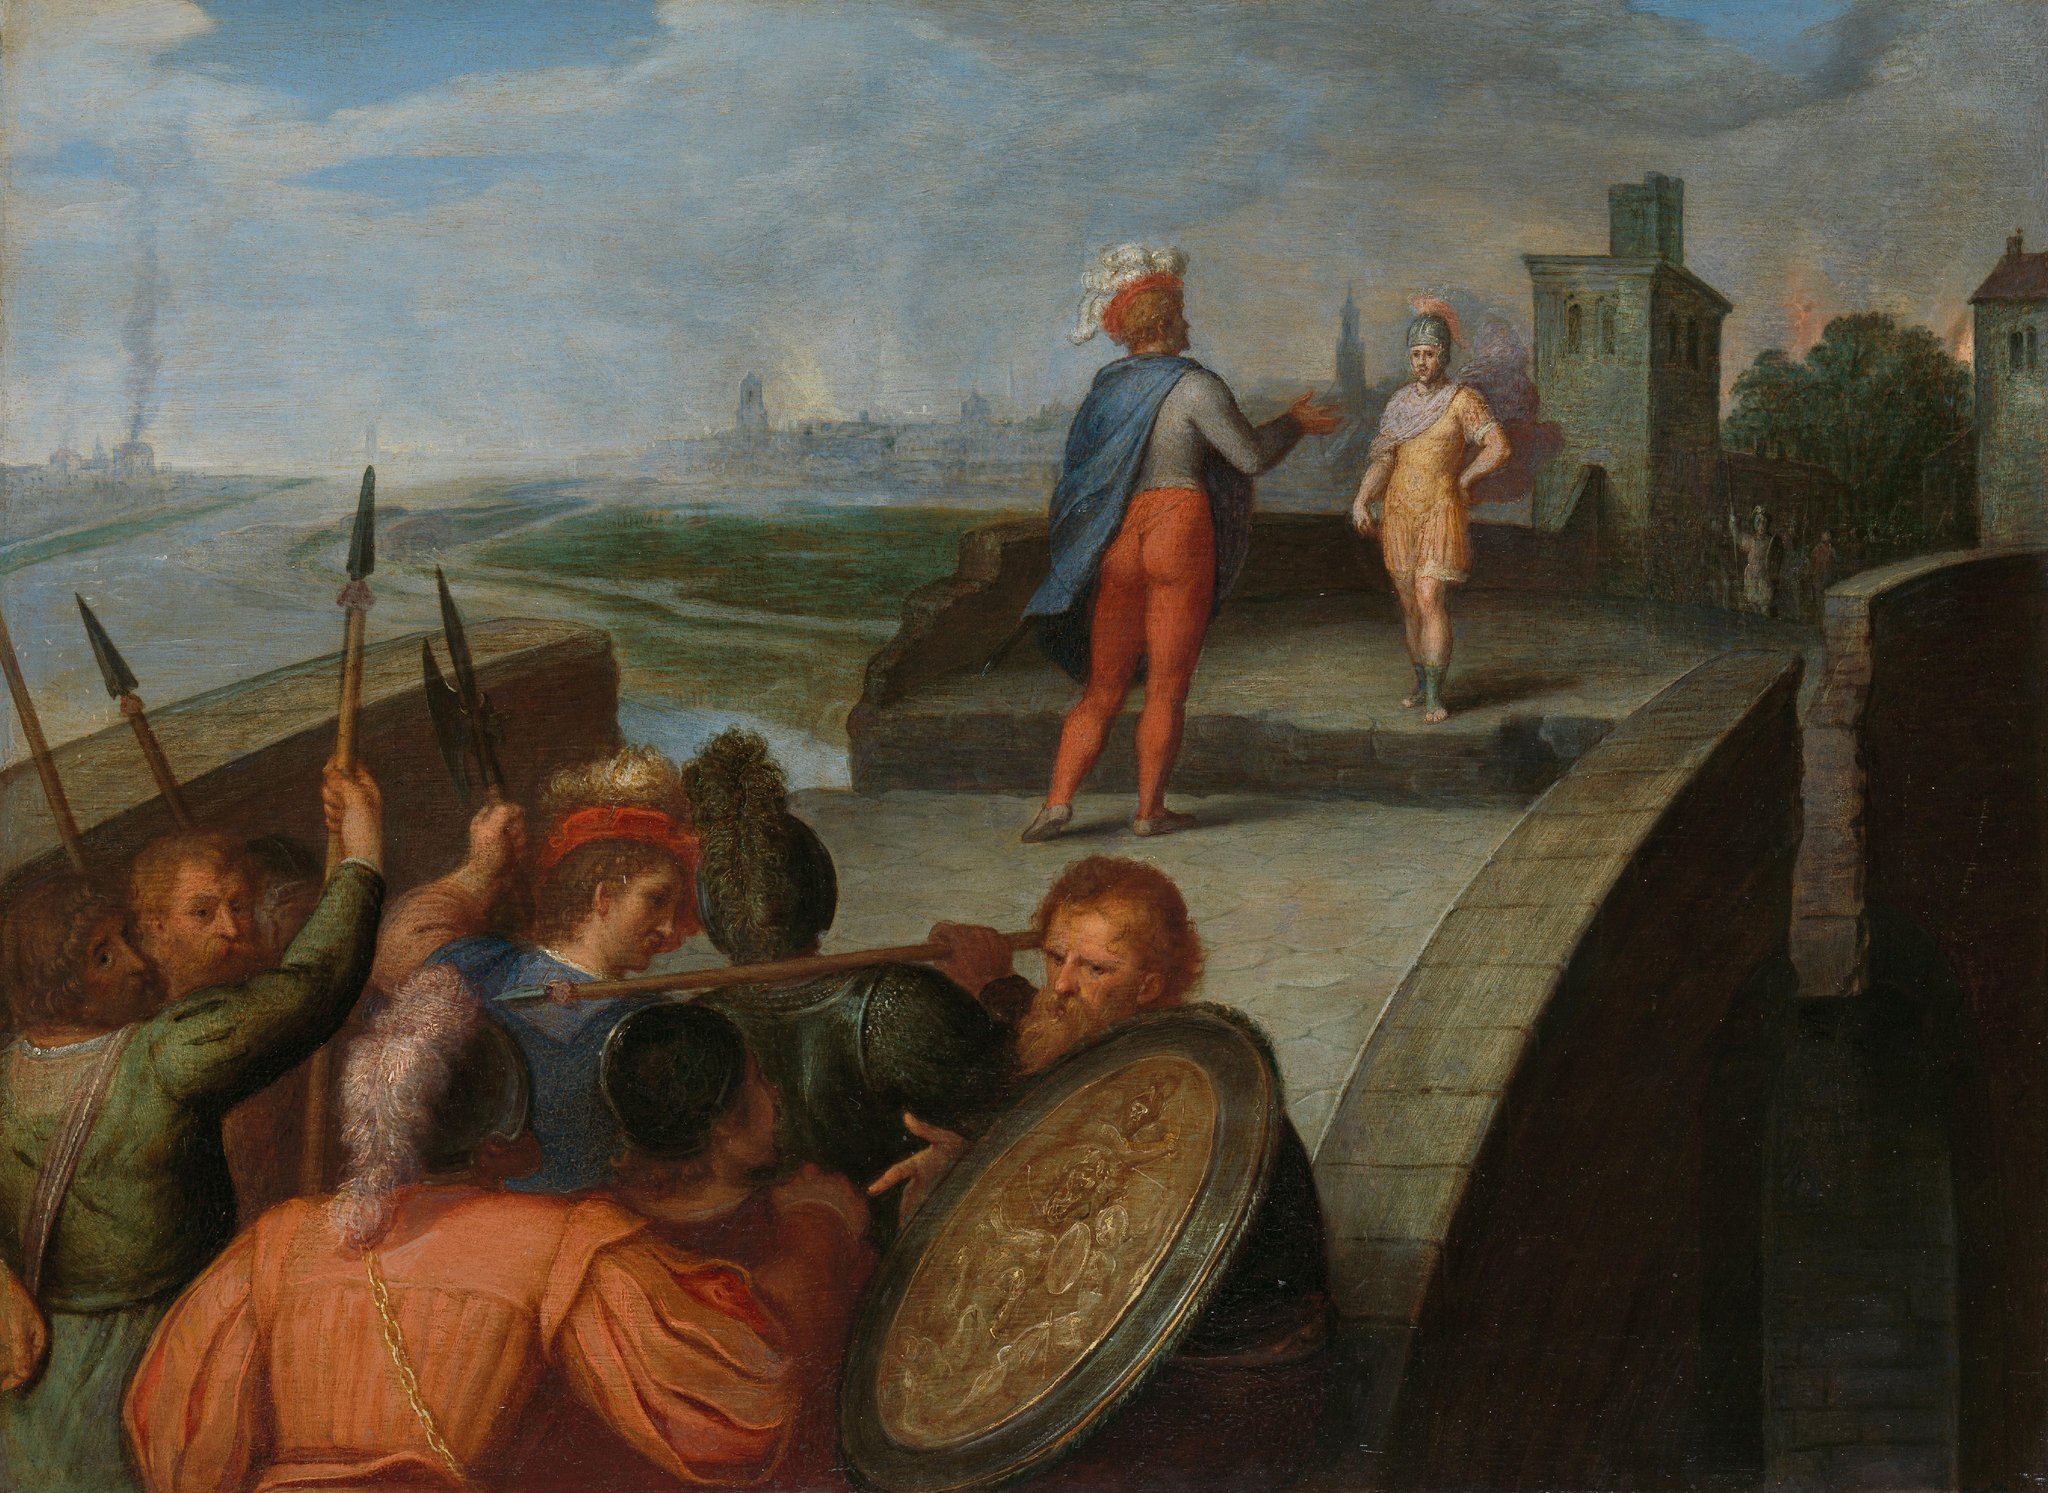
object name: painting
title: one of a series of twelve on the Insurrection of the Batavians against the Romans "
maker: otto van veen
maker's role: draughtsman, painter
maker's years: 1556-1629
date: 1600-1613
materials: oil, panel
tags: negotiations for truce on a demolished bridge, non-aggressive activities of julius claudius civilis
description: In 1613, the Dutch parliament (States General) commissioned Otto van Veen to paint twelve paintings depicting the revolt of the Batavians against the Romans in AD 69 and 70. These were displayed in Binnenhof, the central government building in The Hague. In the early years of the Dutch Republic, many compared their own revolt against Spain to the Batavian uprising.